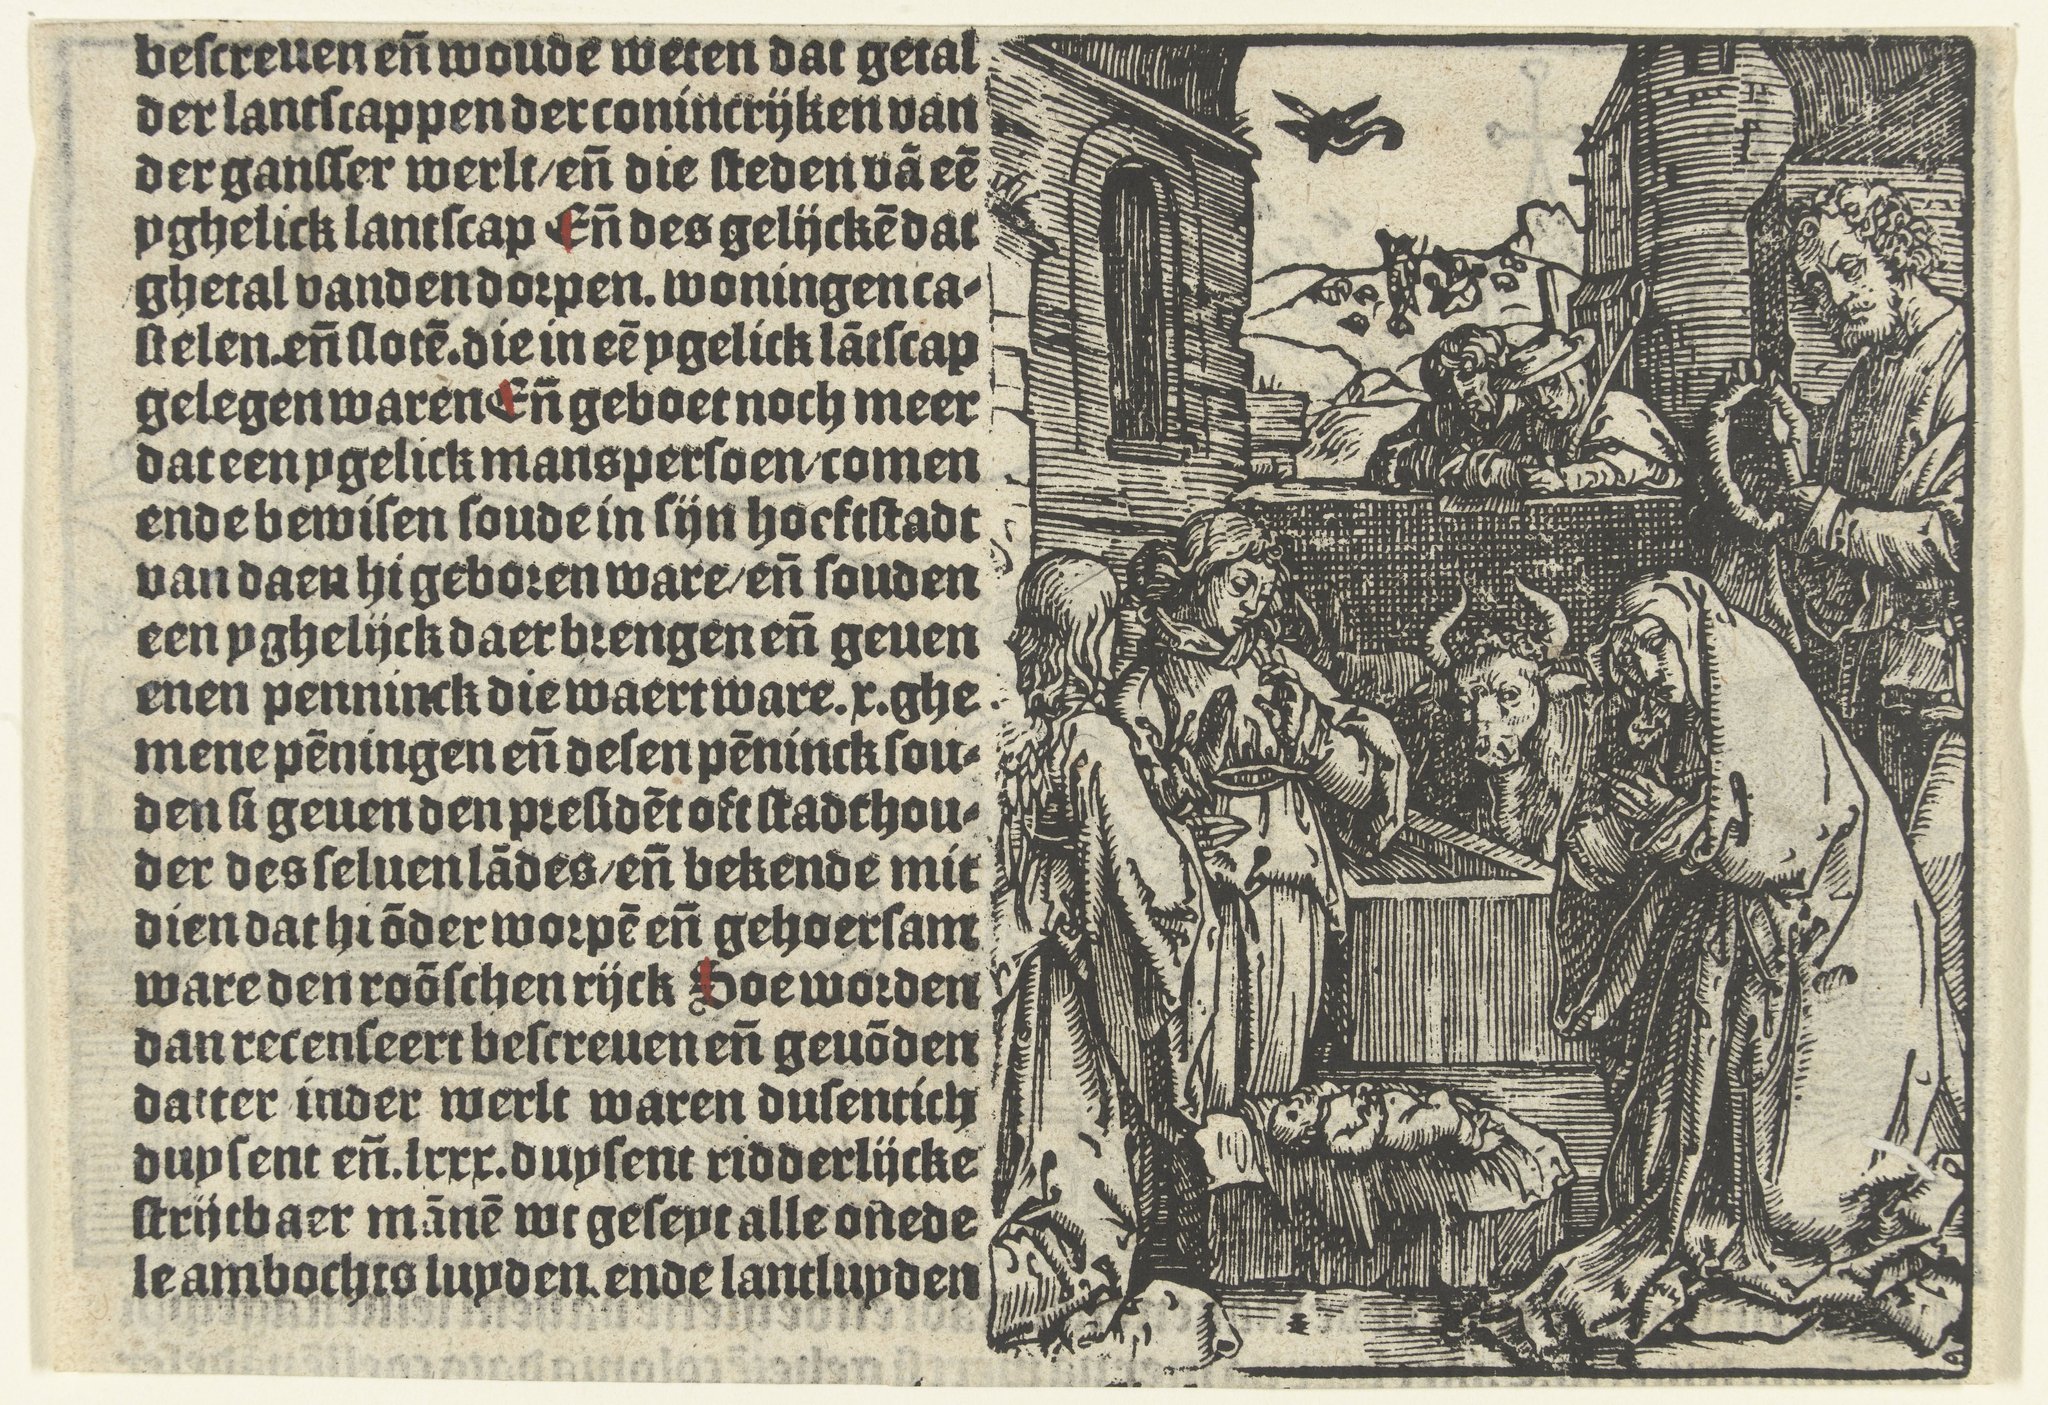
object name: book illustration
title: Scènes uit het leven van Christus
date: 1512-1516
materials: paper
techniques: woodcut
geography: low countries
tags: adoration of the christ-child by the shepherds; mary and joseph present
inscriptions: collector's mark: Lugt 240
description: Uit "Cronycke van Hollandt, Zeelandt ende Vrieslant", uitgegeven door Jan Seversz. te Leiden. Houtsnede gebruikt in de editie van 1517 en van 1517-1530, folio 26v.